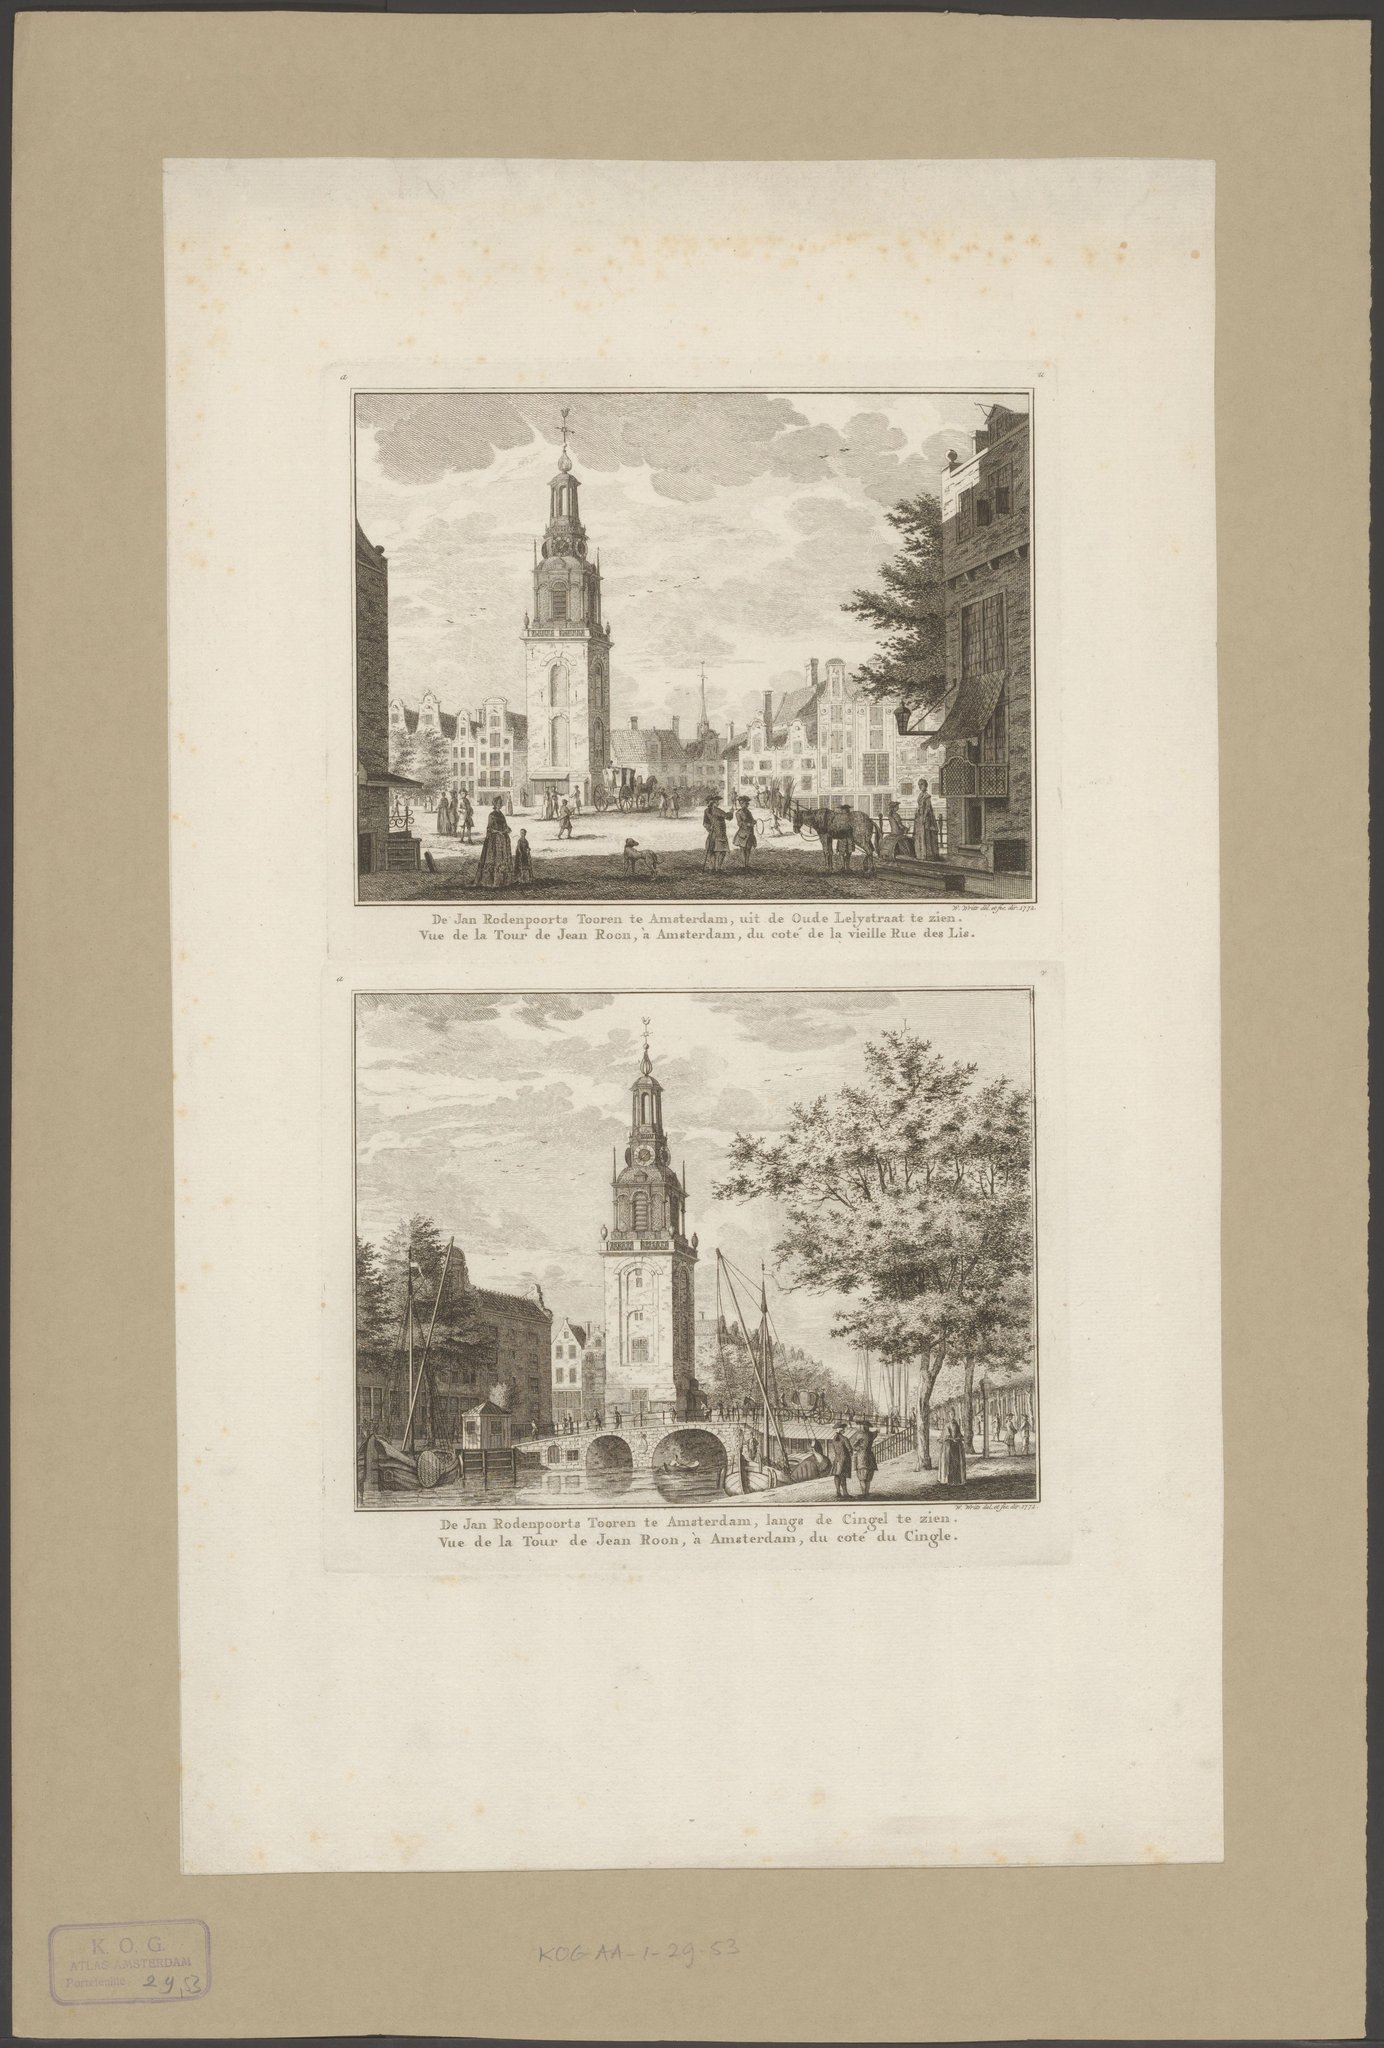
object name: print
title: De Jan Roodenpoorts Tooren te Amsterdam, langs de Cingel te zien / Vue de la Tour de Jean Roon à Amsterdam, du coté du Cingle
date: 1804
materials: paper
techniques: engraving, etching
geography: amsterdam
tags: bridge in city across river, canal, etc. (+ city(-scape) with figures, staffage), sailing-ship, sailing-boat, tower, clock tower ~ monumental adornment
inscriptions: collector's mark: Lugt 1641b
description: Bovenaan bovenste plaat gemerkt: a u. Bovenaan onderste plaat gemerkt: a v. Onderwerpsrubriek binnen de Atlas Amsterdam: Jan Roodenpoortstoren.